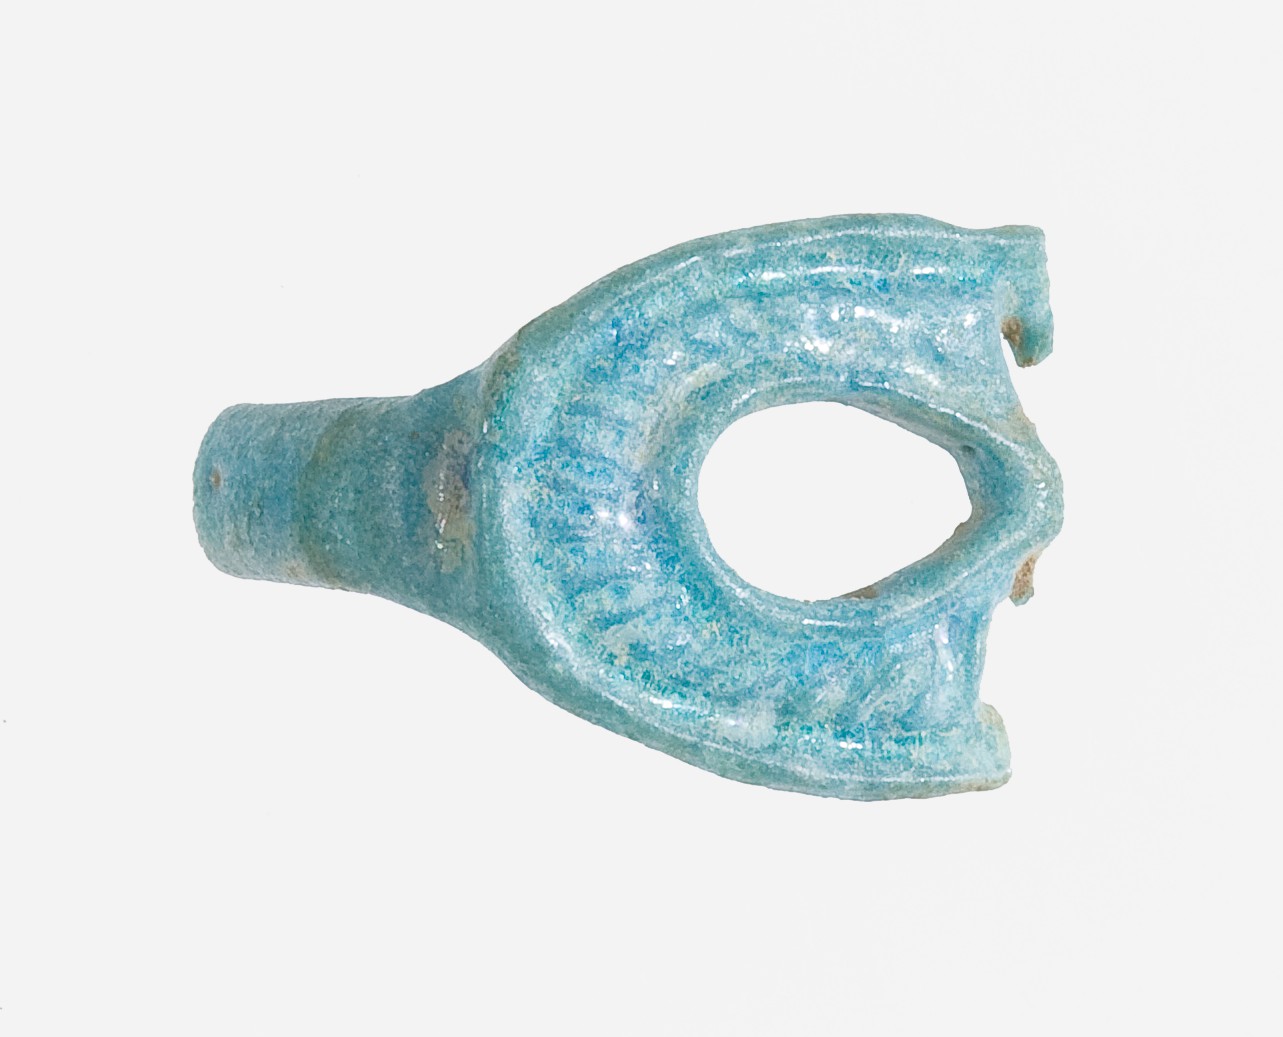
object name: ring fragment, ankh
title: Ankh Ring Fragment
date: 1390-1352 BCE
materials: faience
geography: egypt